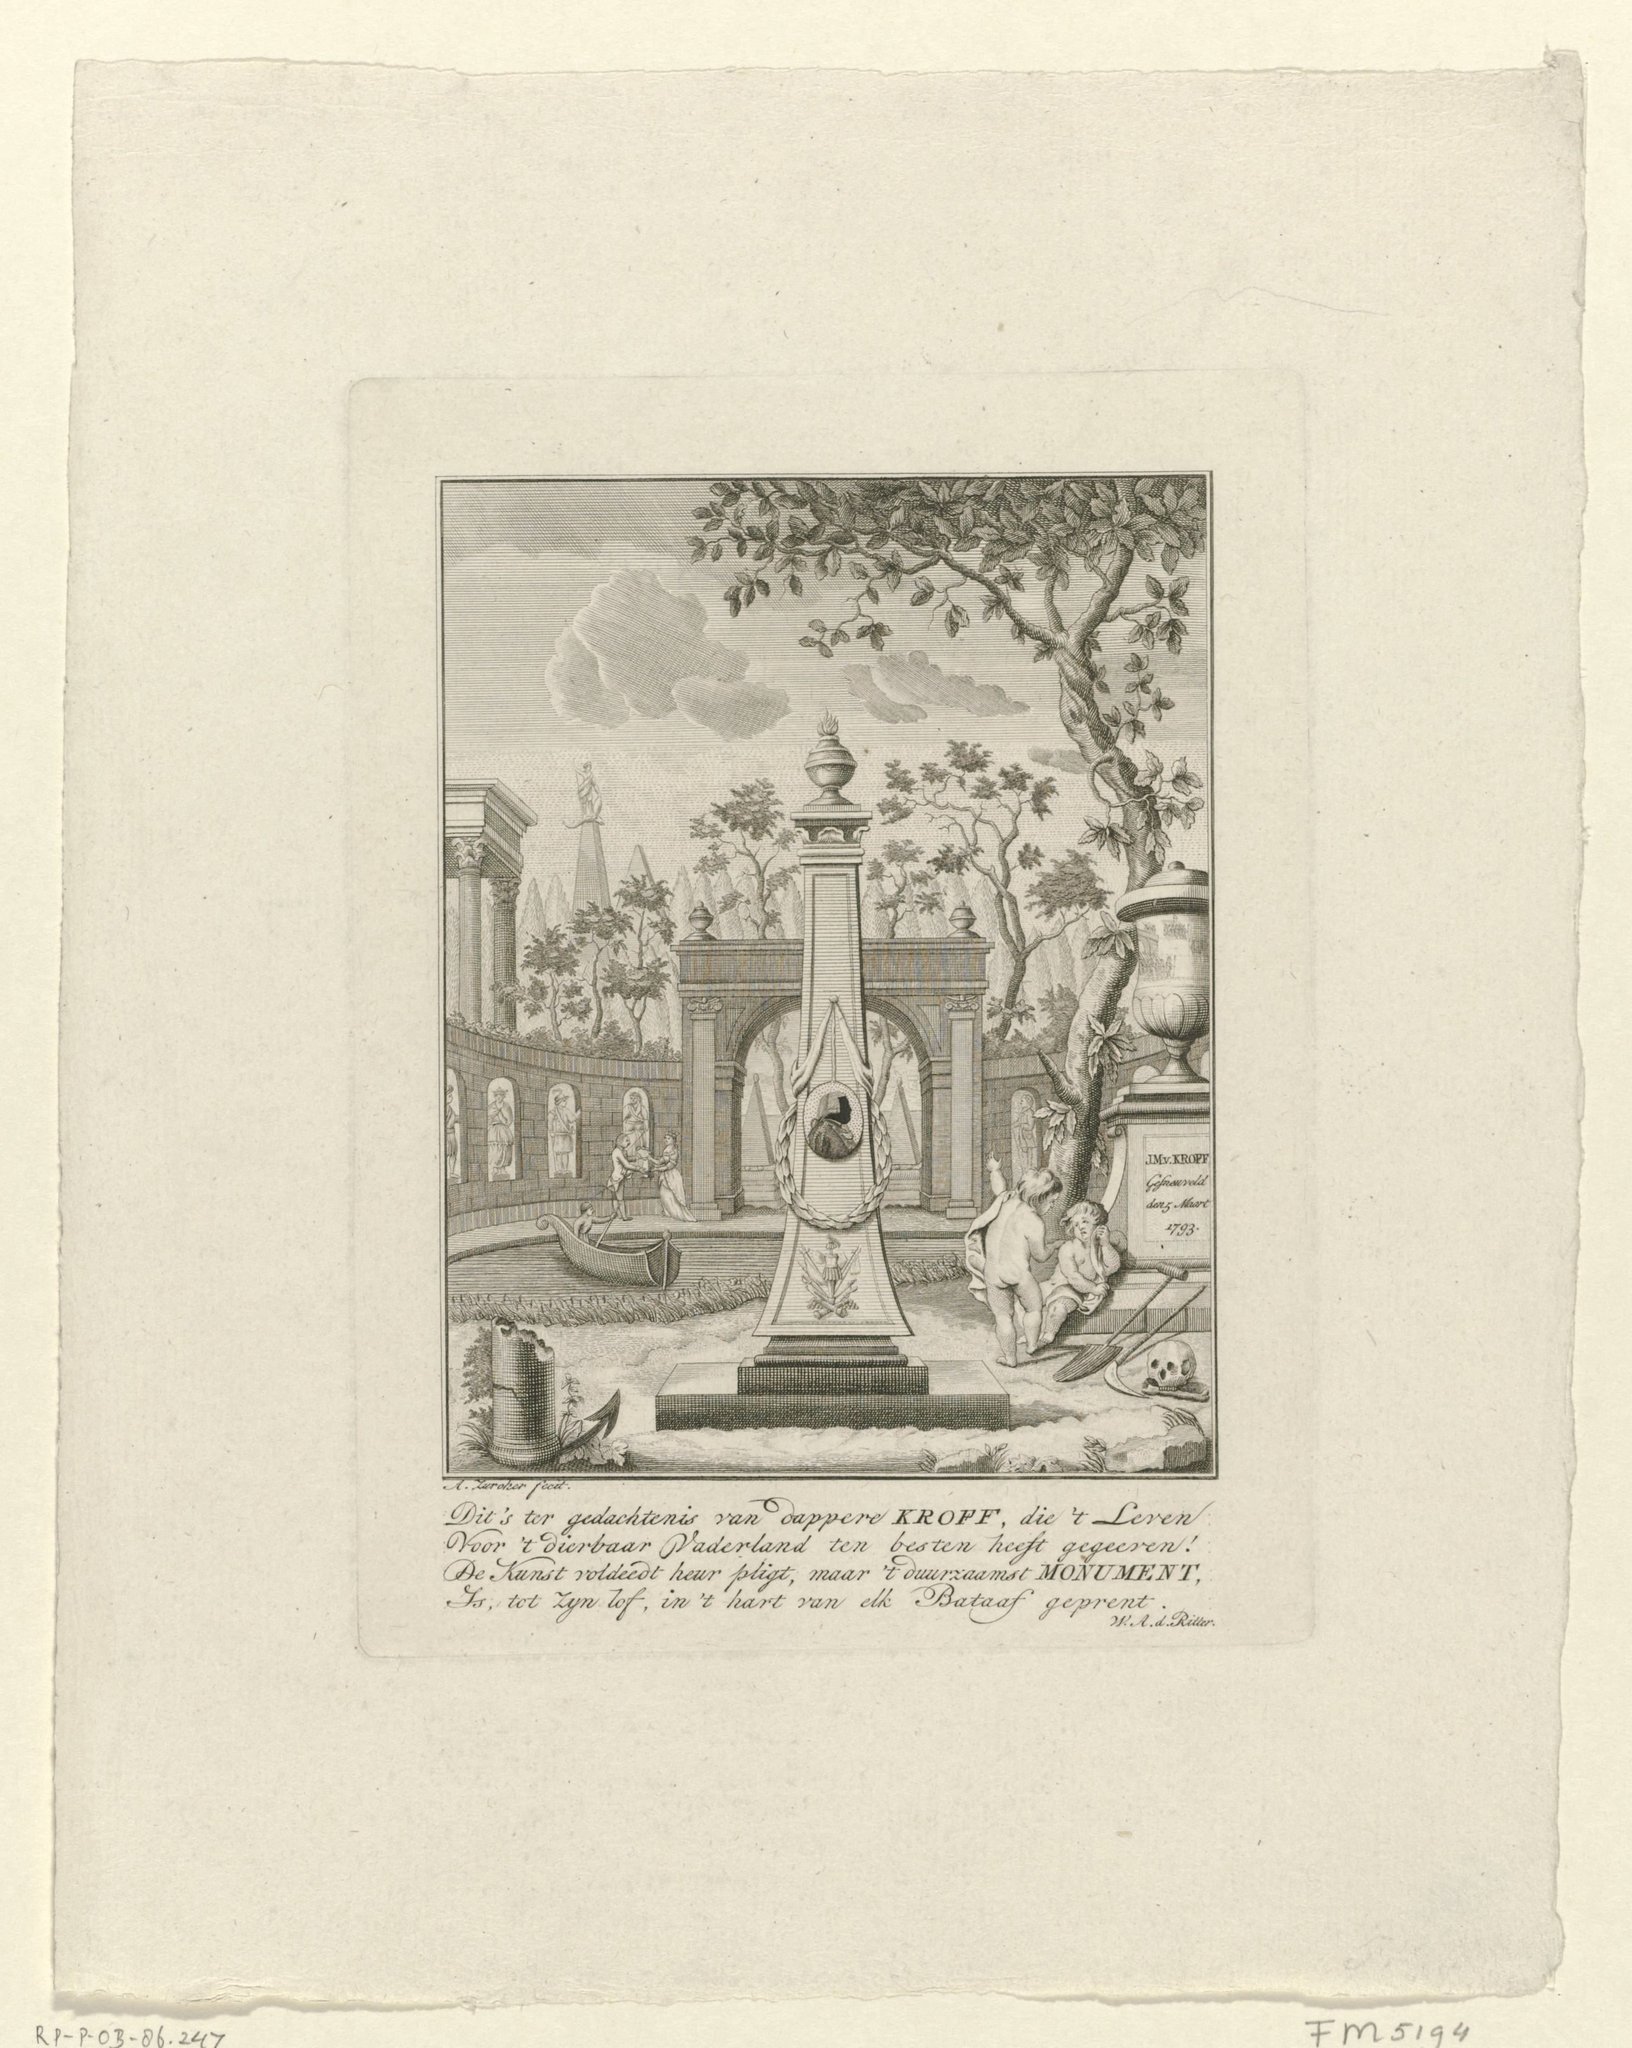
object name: print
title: Monument voor J.M. baron von Kropff, 1793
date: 1793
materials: paper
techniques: engraving, etching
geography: northern netherlands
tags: klundert, grave-building, monumental tomb, charon, the ferryman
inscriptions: collector's mark: Lugt 2228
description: Allegorisch monument voor Joachim Maurits baron van Kropff, gesneuveld bij de verdediging van Klundert tegen het Franse leger, 25 februari 1793. Grafnaald in een hof met rechts twee treurende kinderen bij een grote urn. Op de achtergrond wordt Kropff door Charon met de boot de rivier overgezet. Met vierregelig vers.